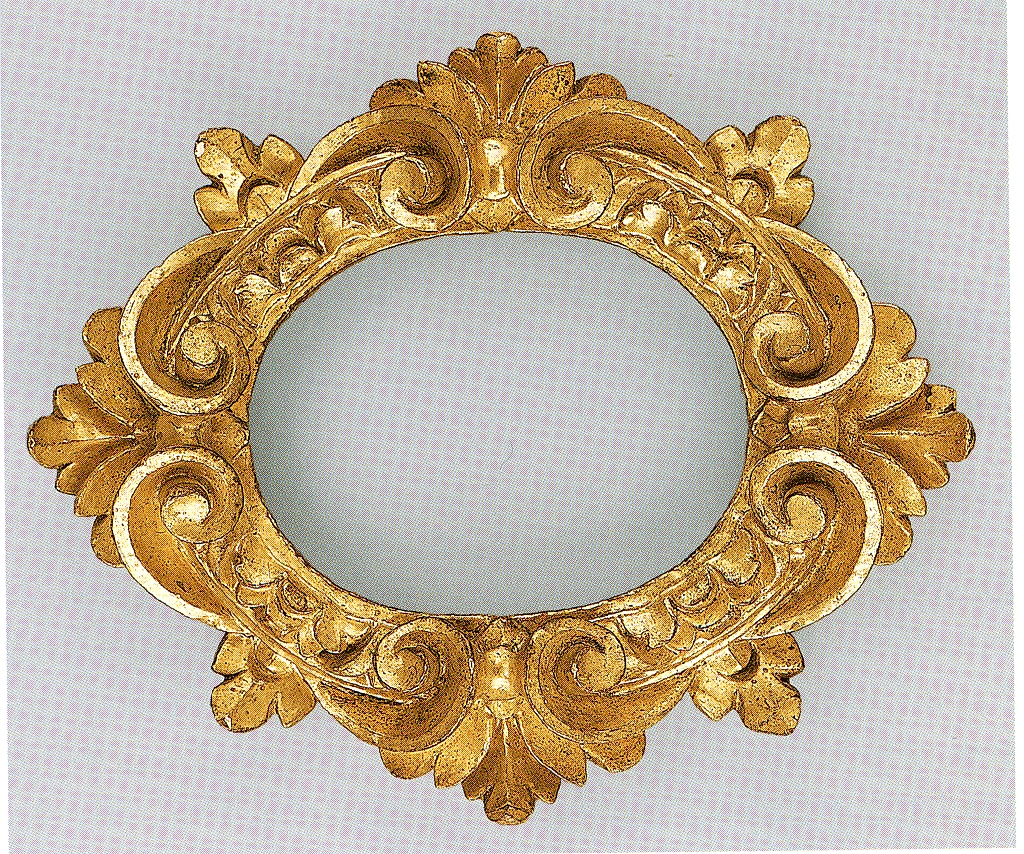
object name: frame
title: Sansovino-style oval frame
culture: italian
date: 1801-1900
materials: wood